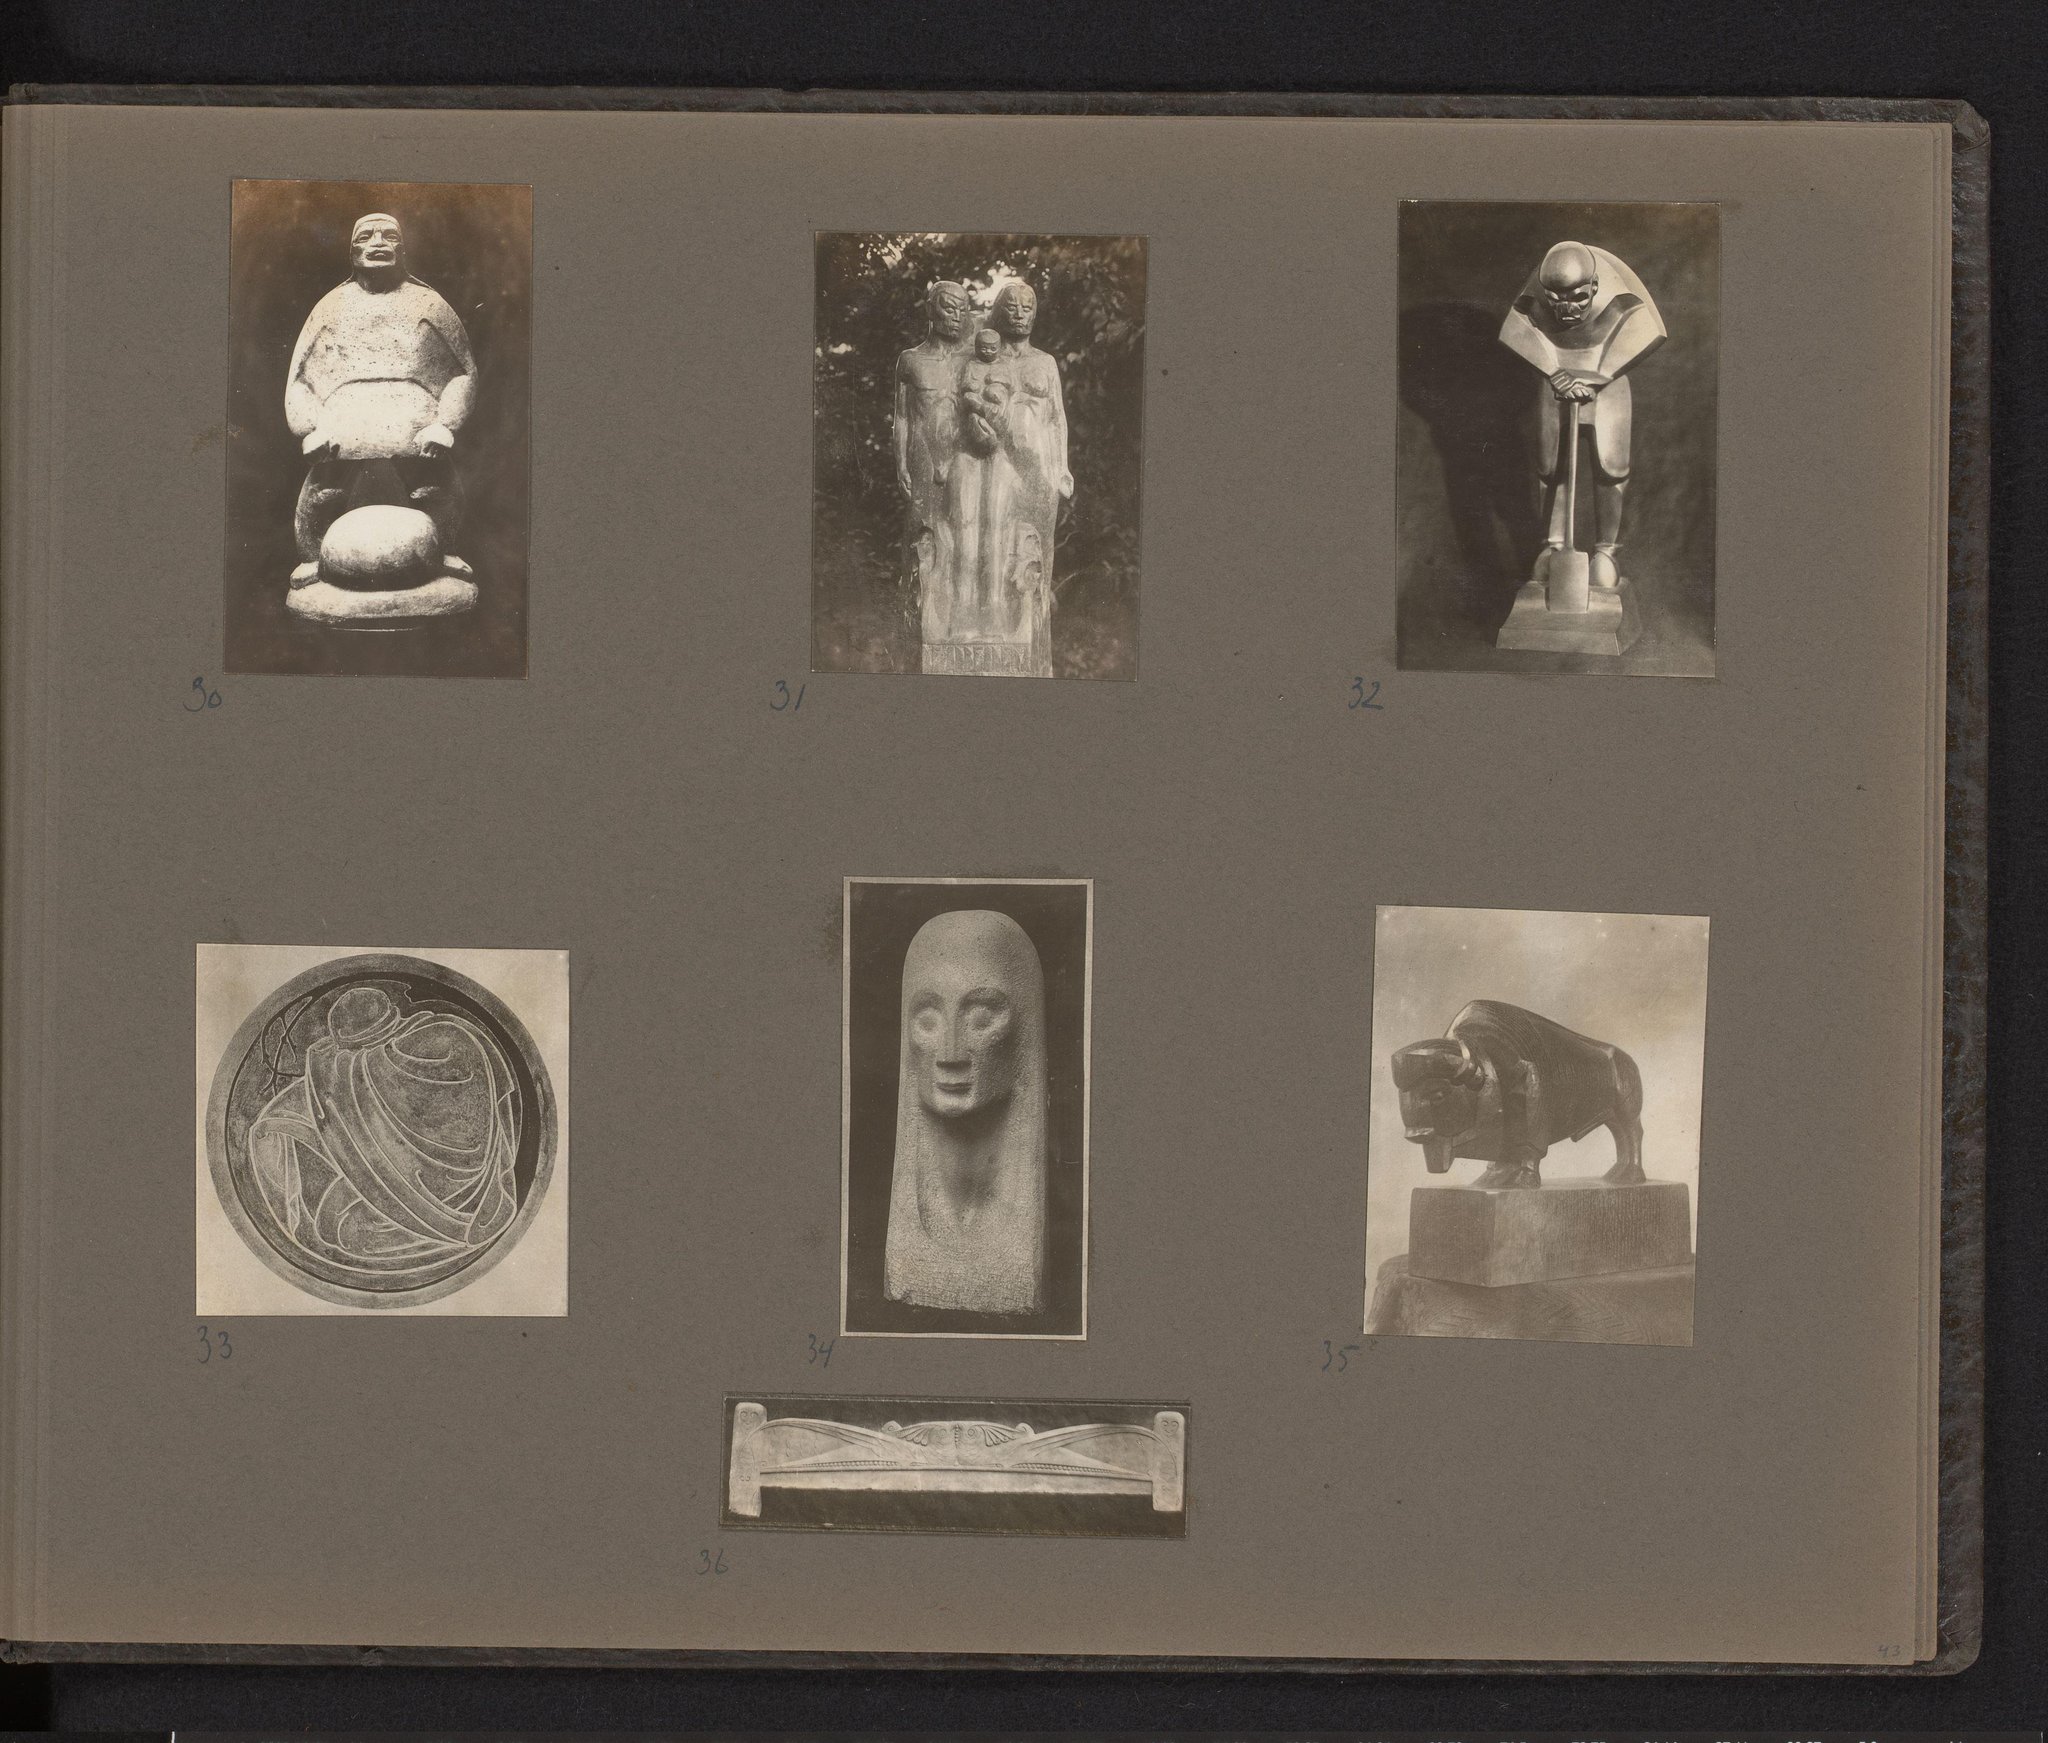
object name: photograph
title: Vijf sculpturen en twee reliëfs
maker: Anonymous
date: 1920-1940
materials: paper, photographic support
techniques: gelatin silver print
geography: netherlands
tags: bull, parents with their children, adult man, piece of sculpture, reproduction of a piece of sculpture, head (human) - aa - female human figure, sculpture (+ relief ~ sculpture)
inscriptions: number: ‘30 - 31 - 32/ 33 - 34 - 35/ 36’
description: Afgebeeld zijn sculpturen van een man, een gezin, een man met een schep, het hoofd van een vrouw en een stier en twee geabstraheerde reliëfs. Deze foto's maken deel uit van een album.